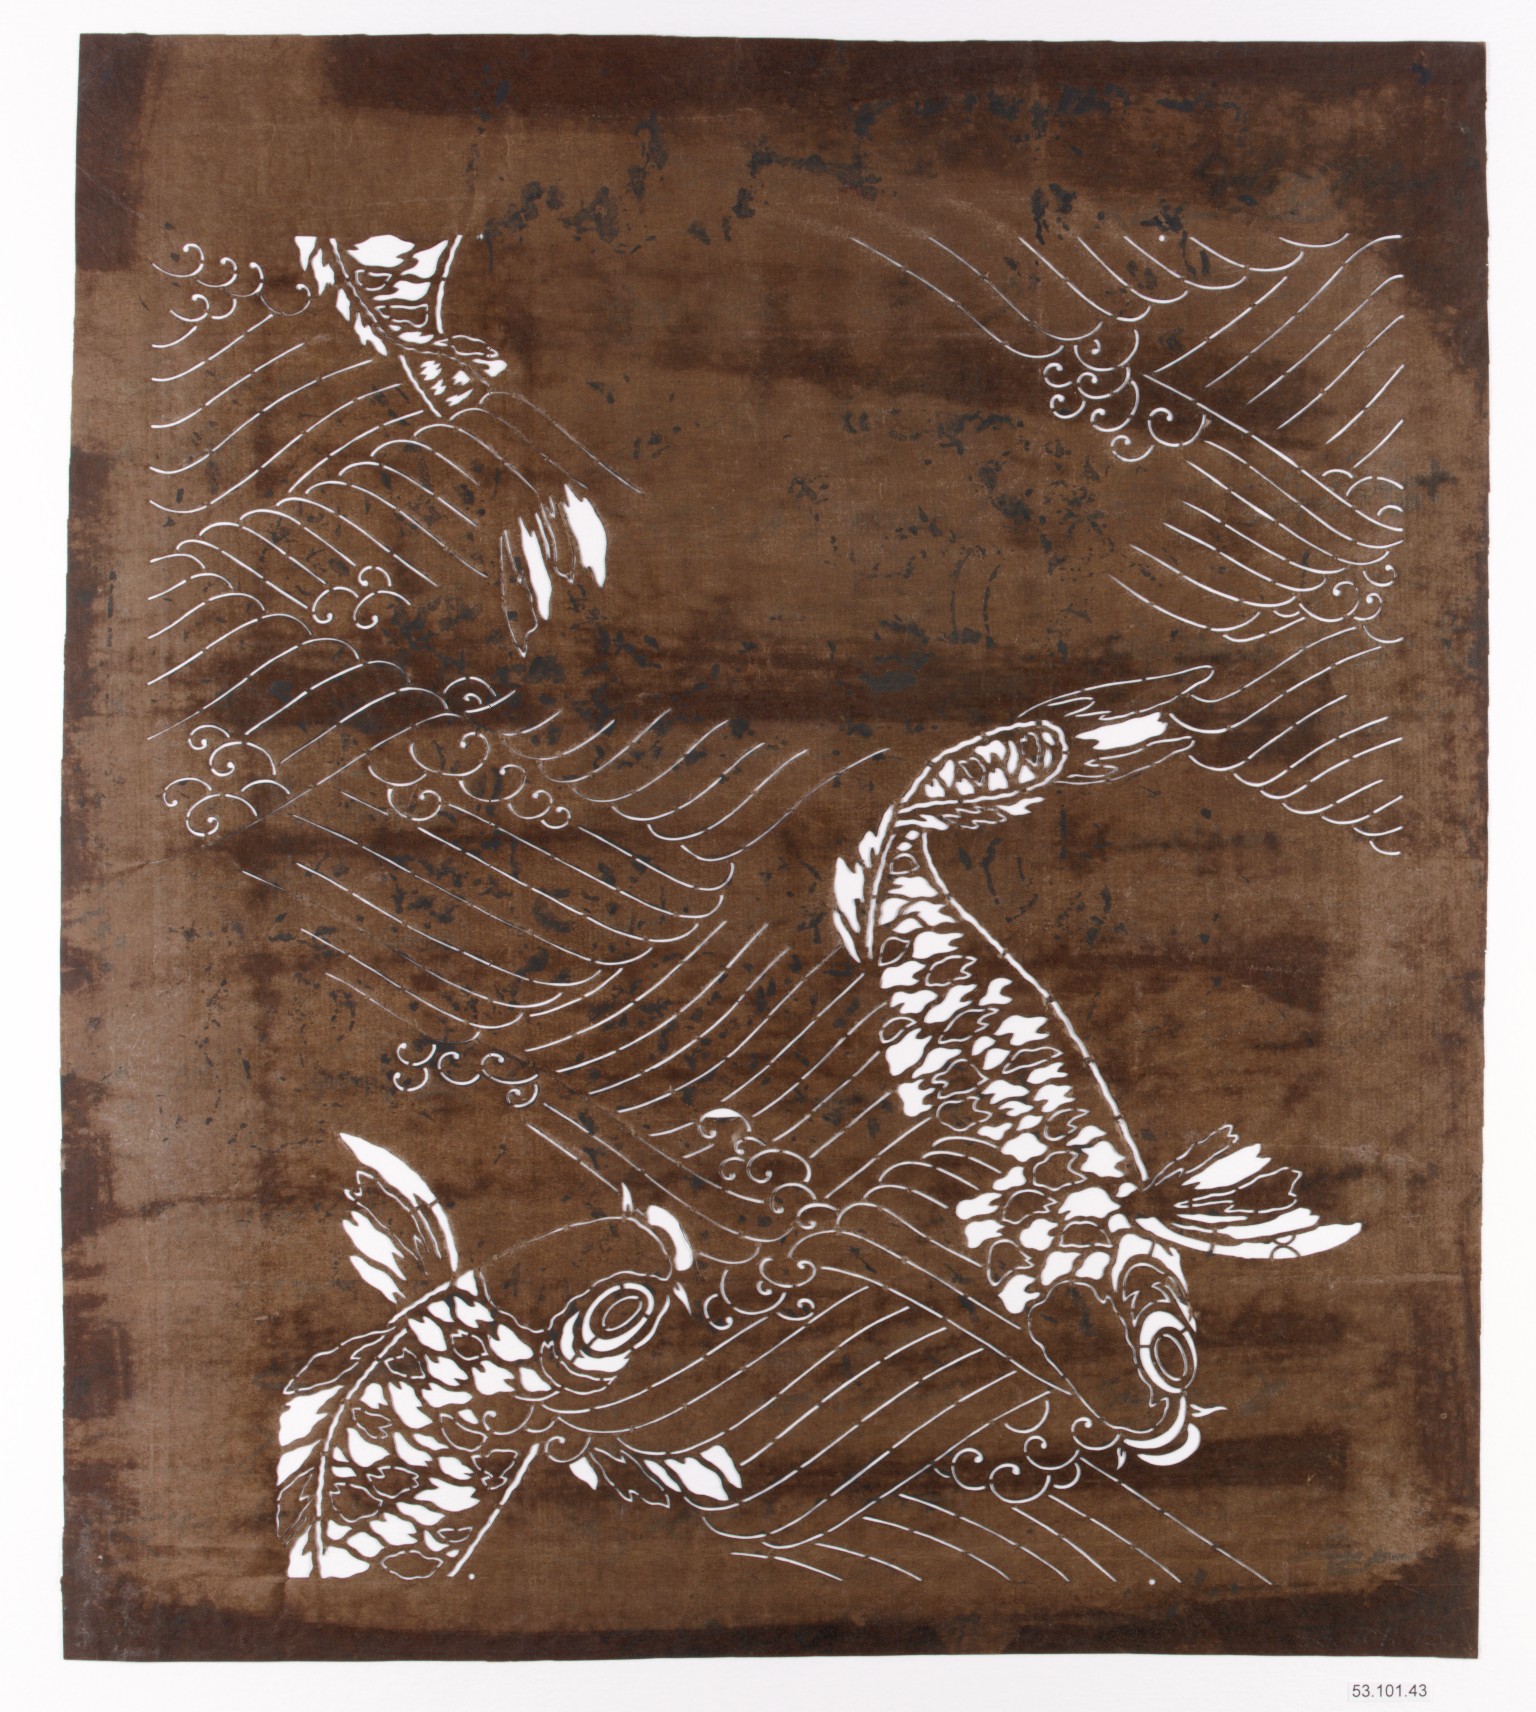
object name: stencil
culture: japanese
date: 1615-1868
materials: paper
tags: fish